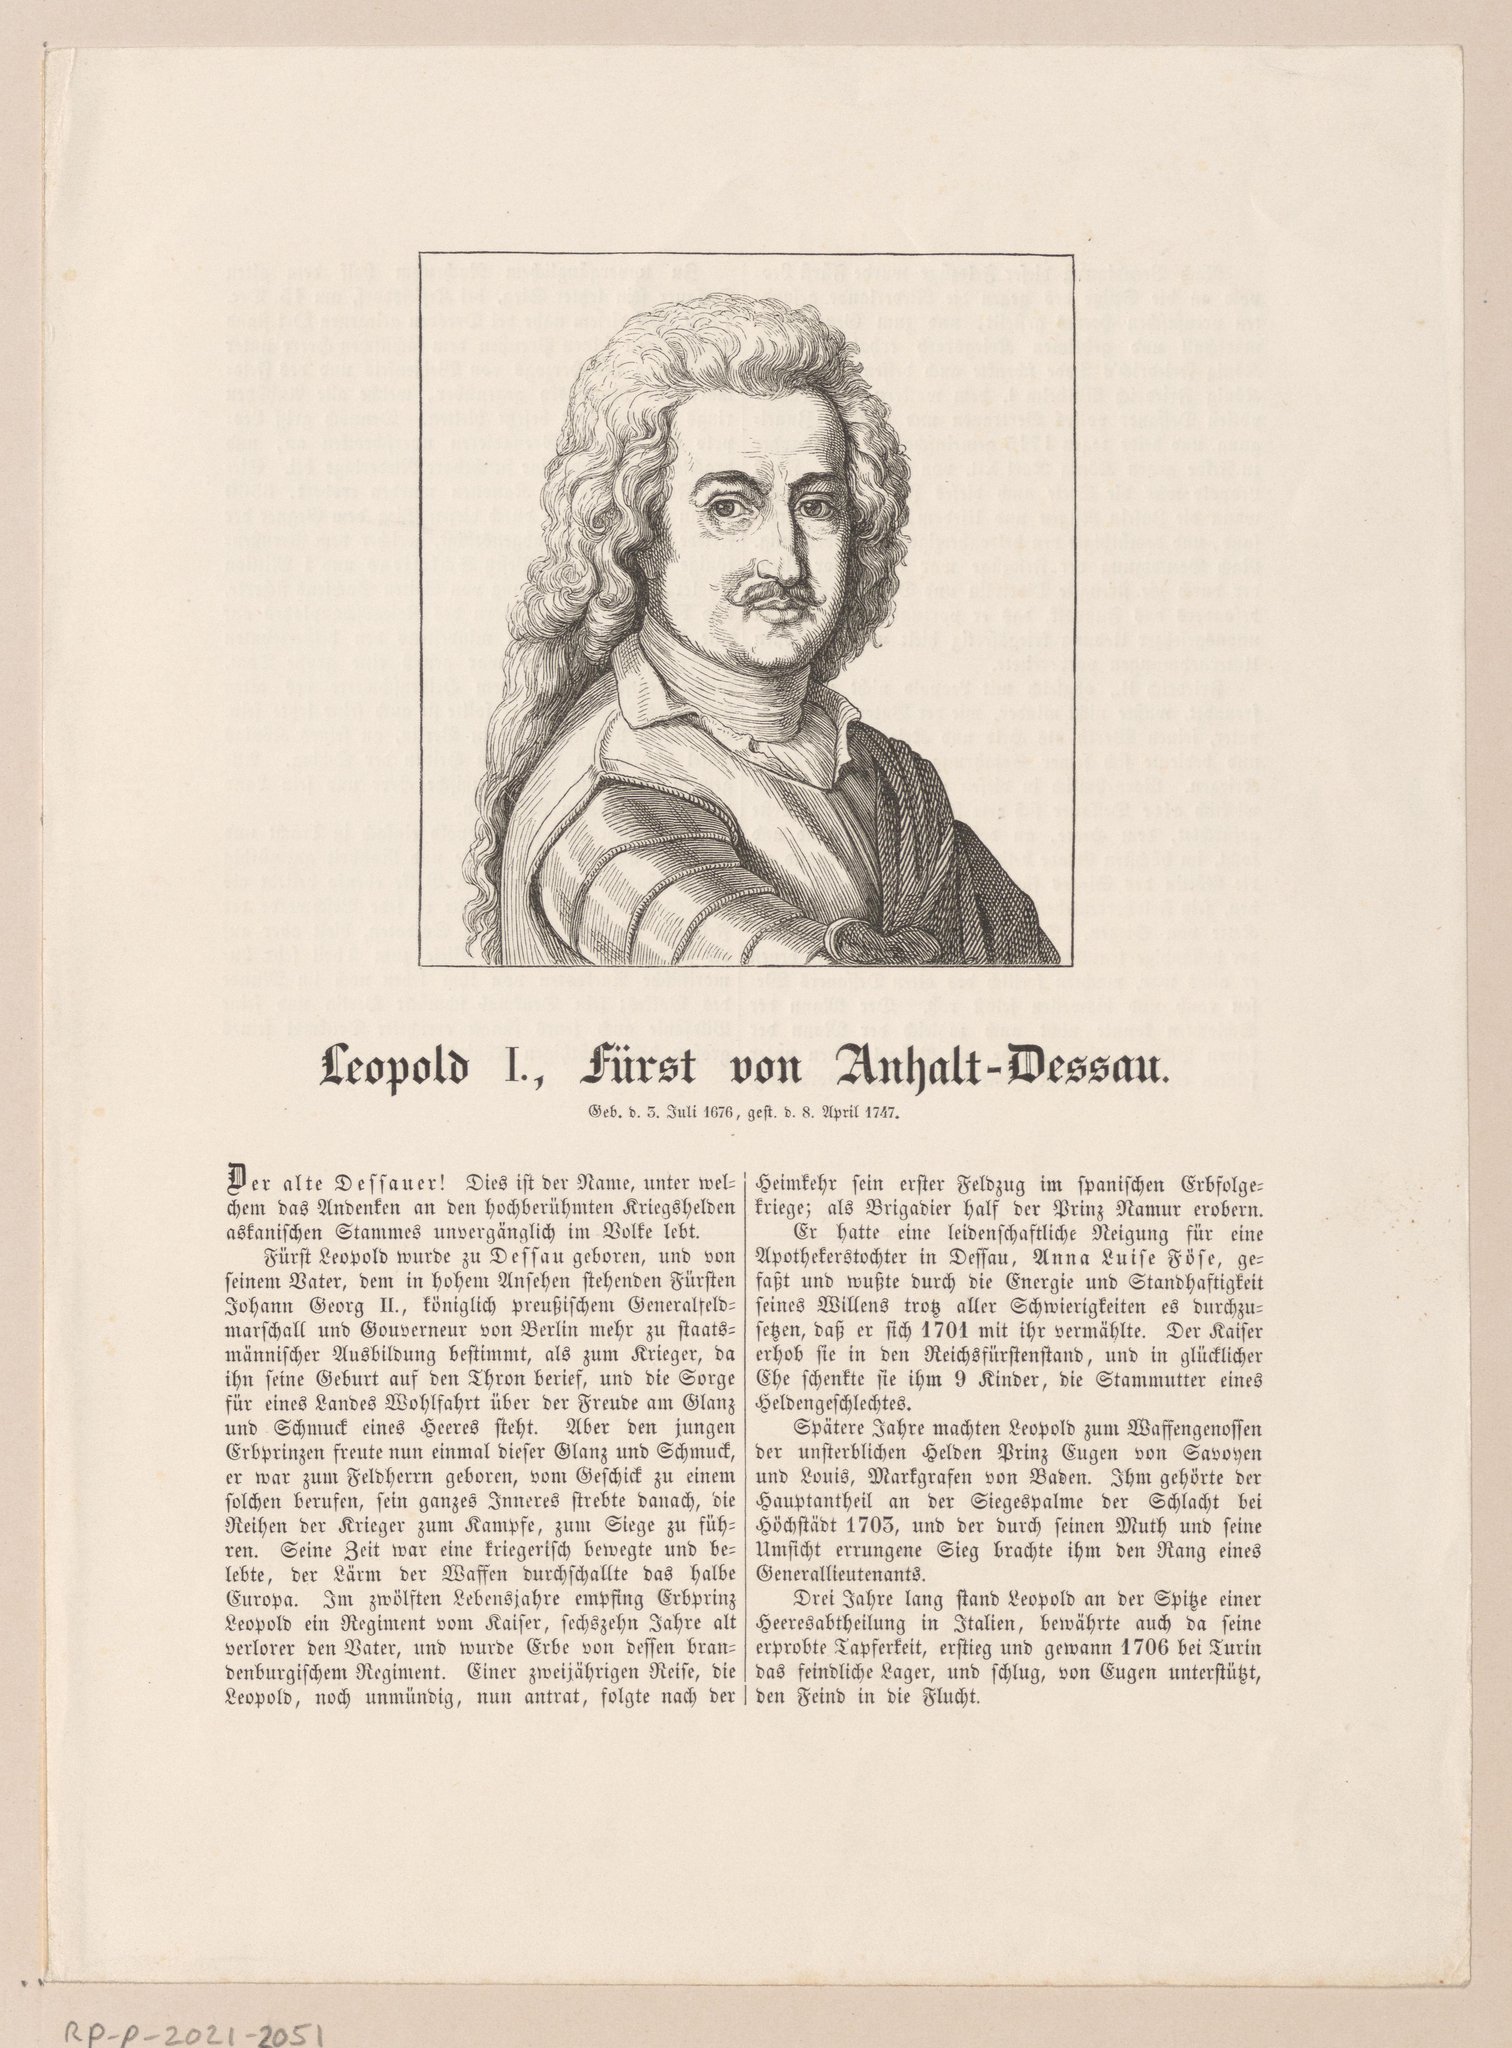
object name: print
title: Portret van Leopold I van Anhalt-Dessau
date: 1854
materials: paper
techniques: letterpress printing, engraving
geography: leipzig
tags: armour, historical persons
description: Bladzijde uit: Bechstein, Ludwig. Zweihundert deutsche Männer in Bildnissen und Lebensbeschreibungen. Leipzig: Georg Wigand, 1854. Prent ook gebruikt in 'Dreihundert Bildnisse und Lebensabrisse berühmter deutscher Männer', waarbij op de titelpagina vermeld staat dat de prenten zijn gemaakt door Hugo Bürkner.